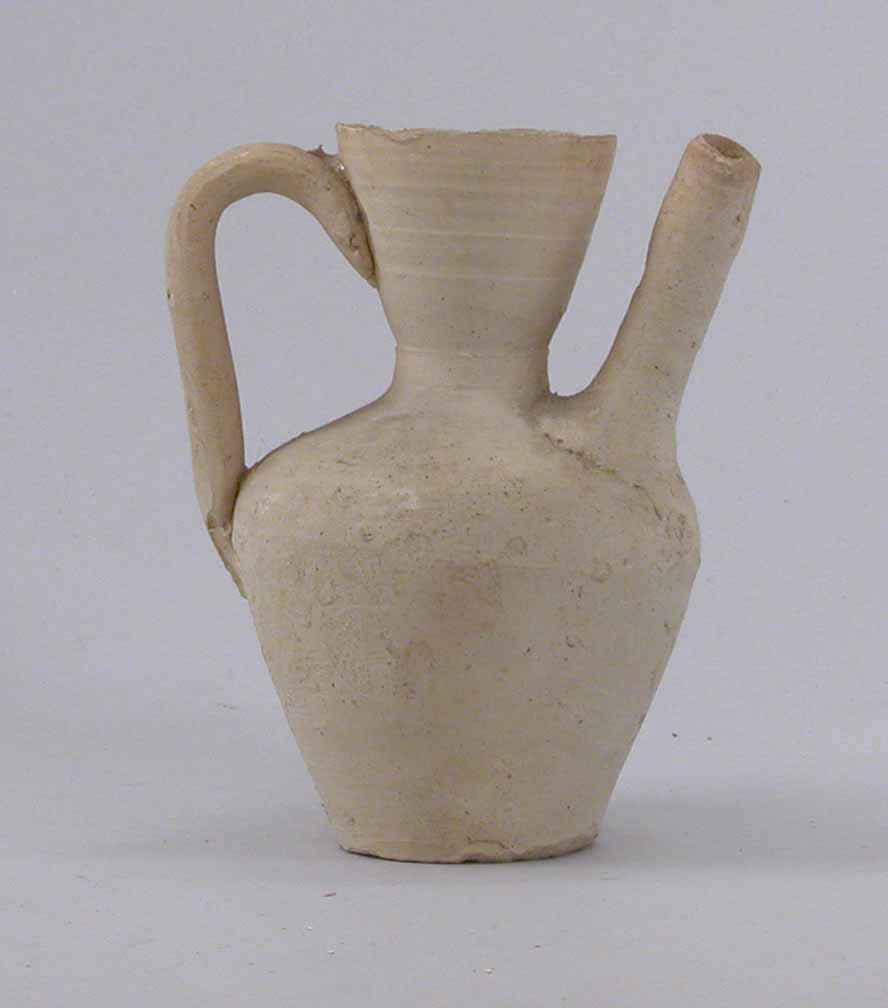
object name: ewer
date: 801-1000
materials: earthenware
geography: iran